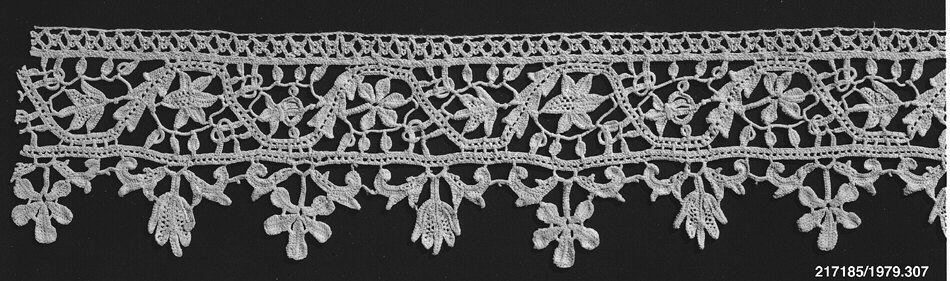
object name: strip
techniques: lace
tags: flowers